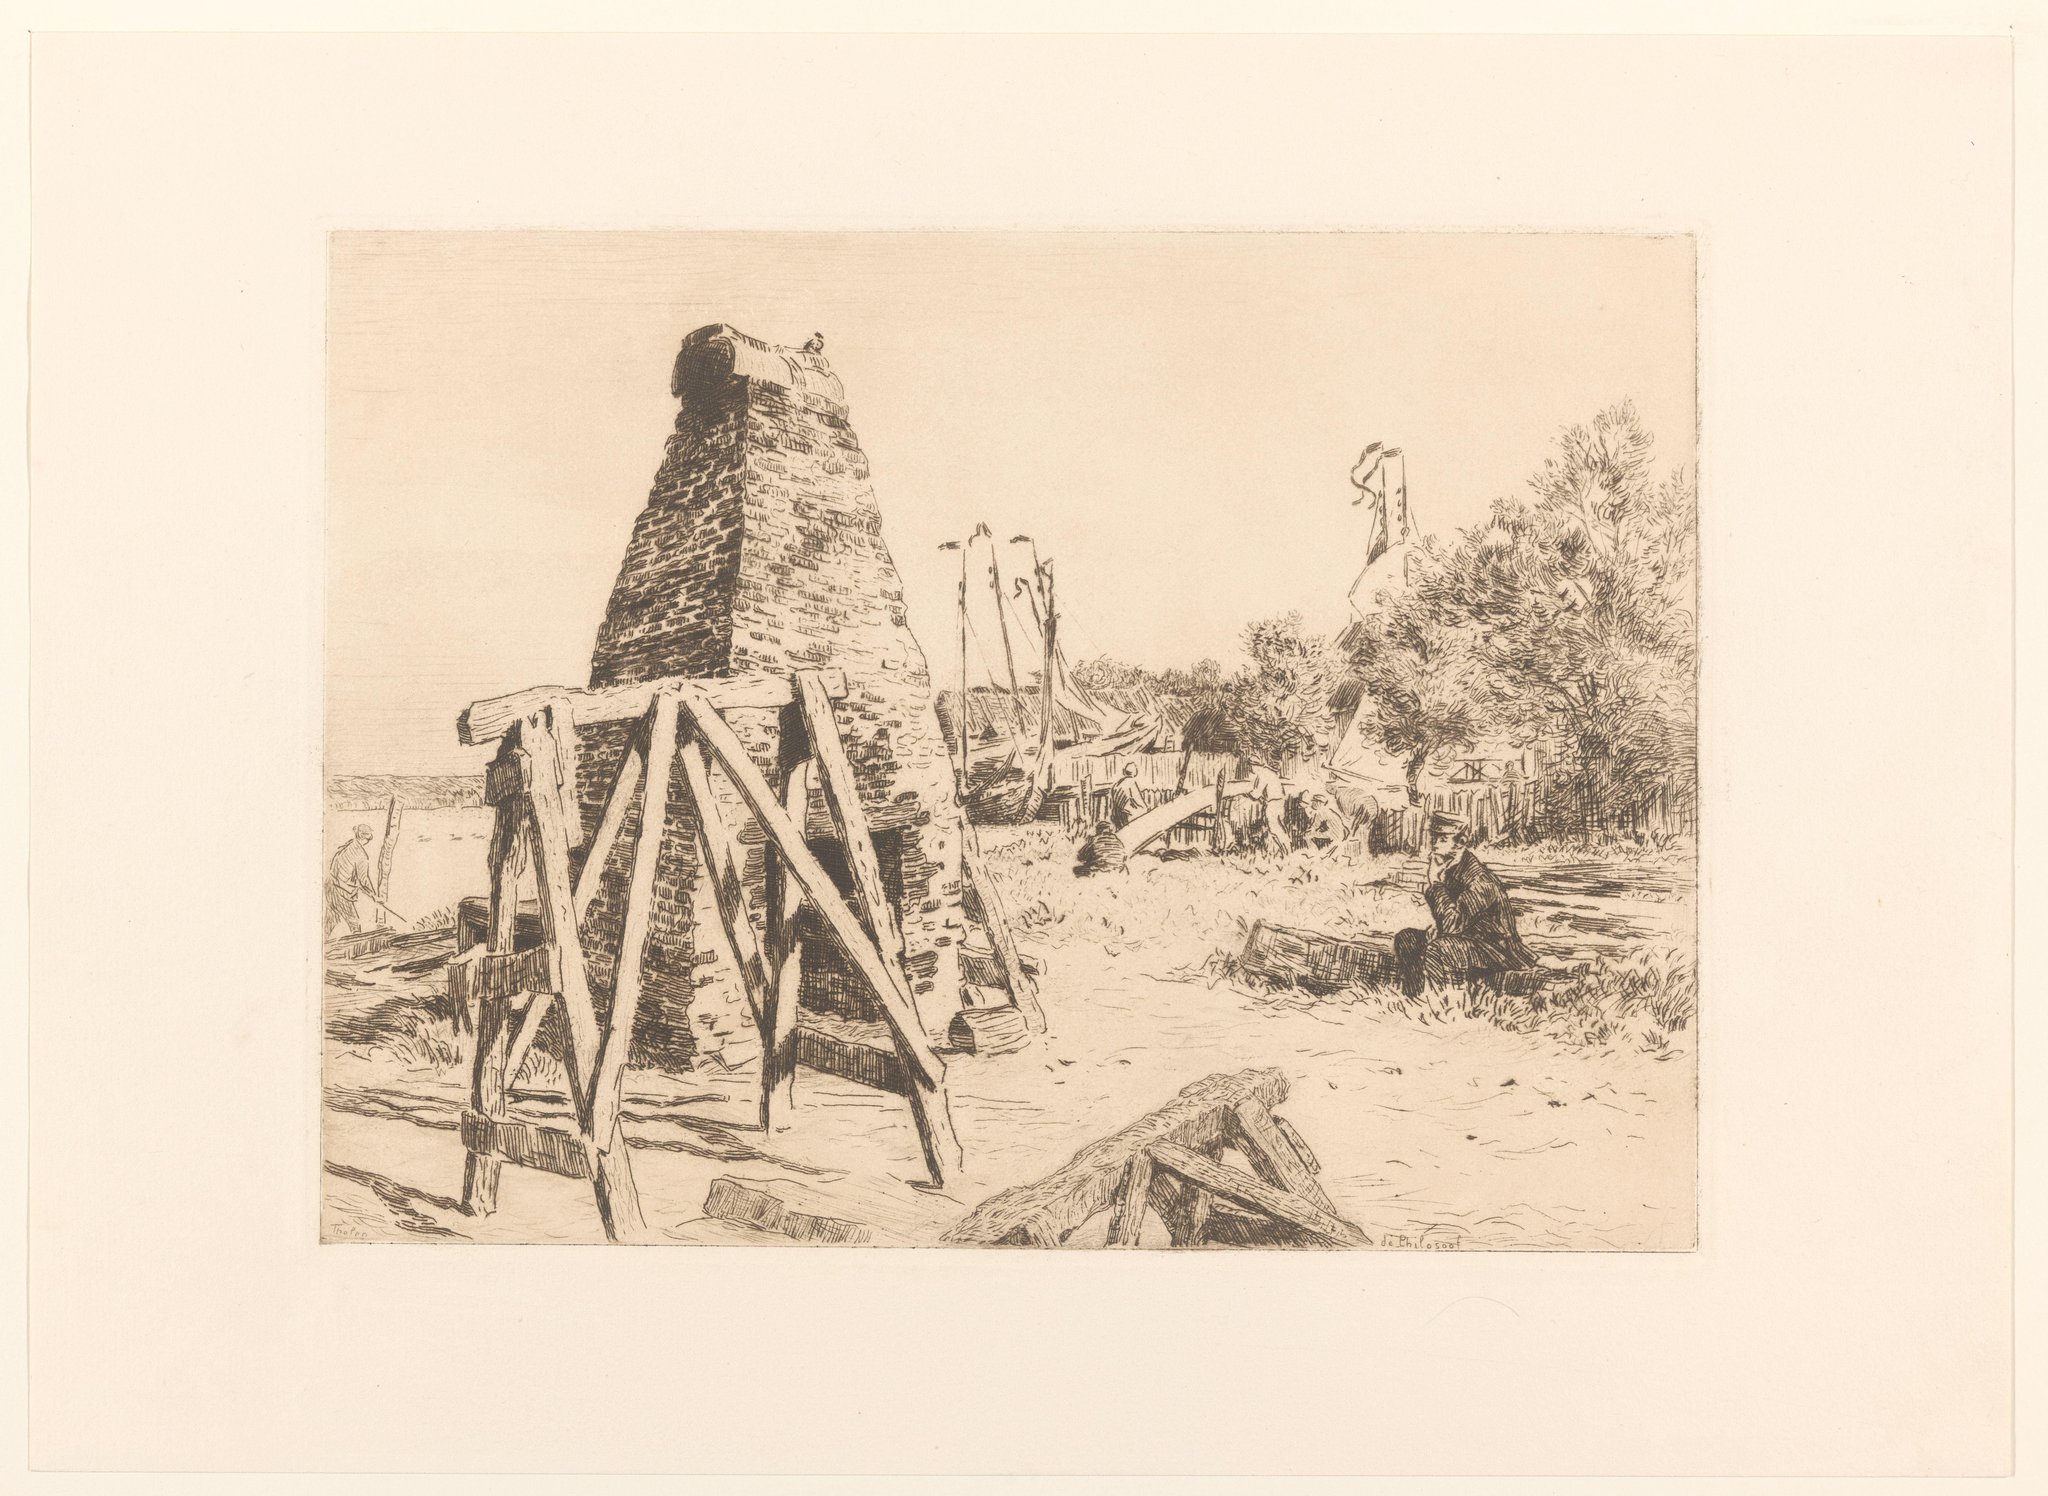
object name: print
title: De Philosoof (werf te Monnikendam)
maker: willem bastiaan tholen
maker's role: draughtsman, painter, print maker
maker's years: 1860-1931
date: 1870-1931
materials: paper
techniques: etching, intaglio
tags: shipyard, shipdock, open fire, fire-place, stove (in kitchen) - cc - in the open air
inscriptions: collector's mark: Lugt 2228